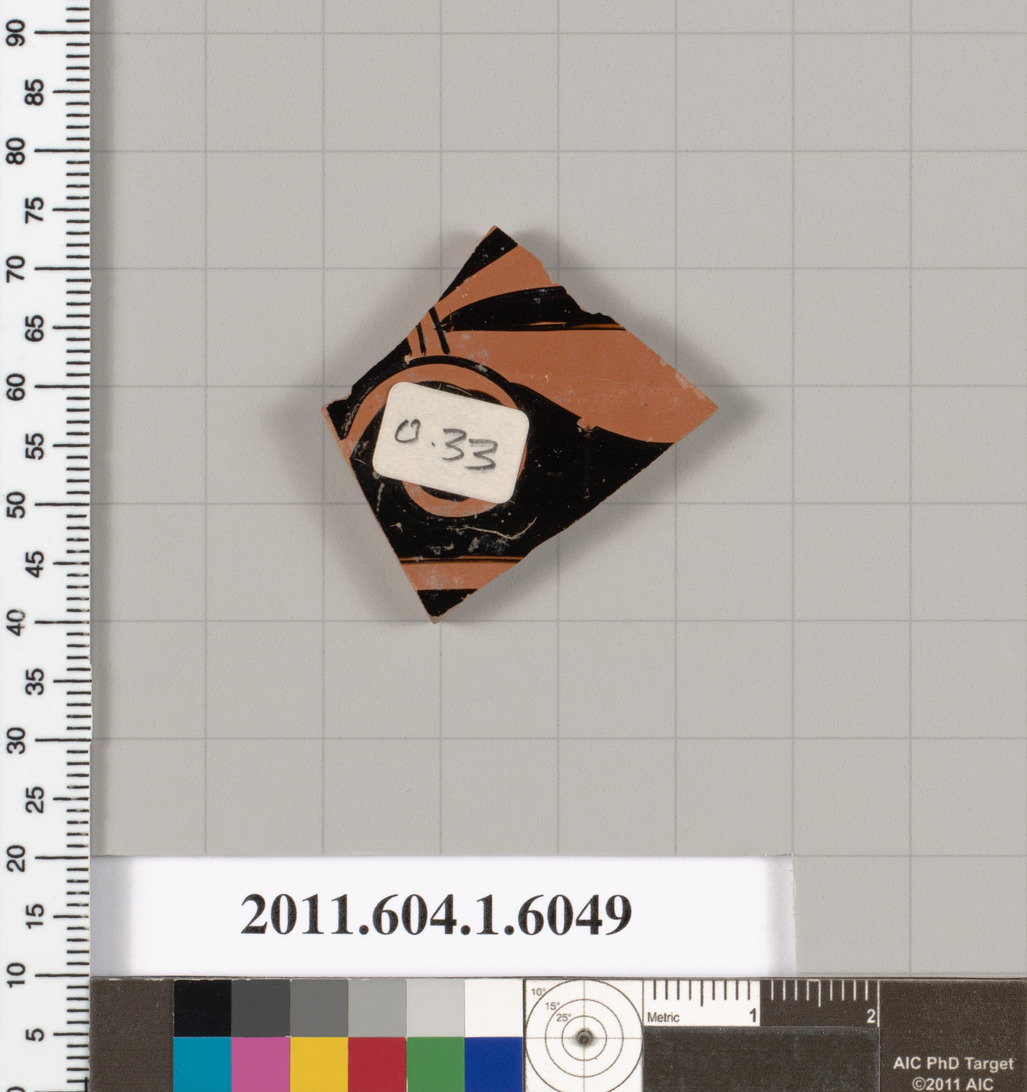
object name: kylix fragment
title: Terracotta fragment of a kylix (drinking cup)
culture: greek, attic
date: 510-500 BCE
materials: terracotta